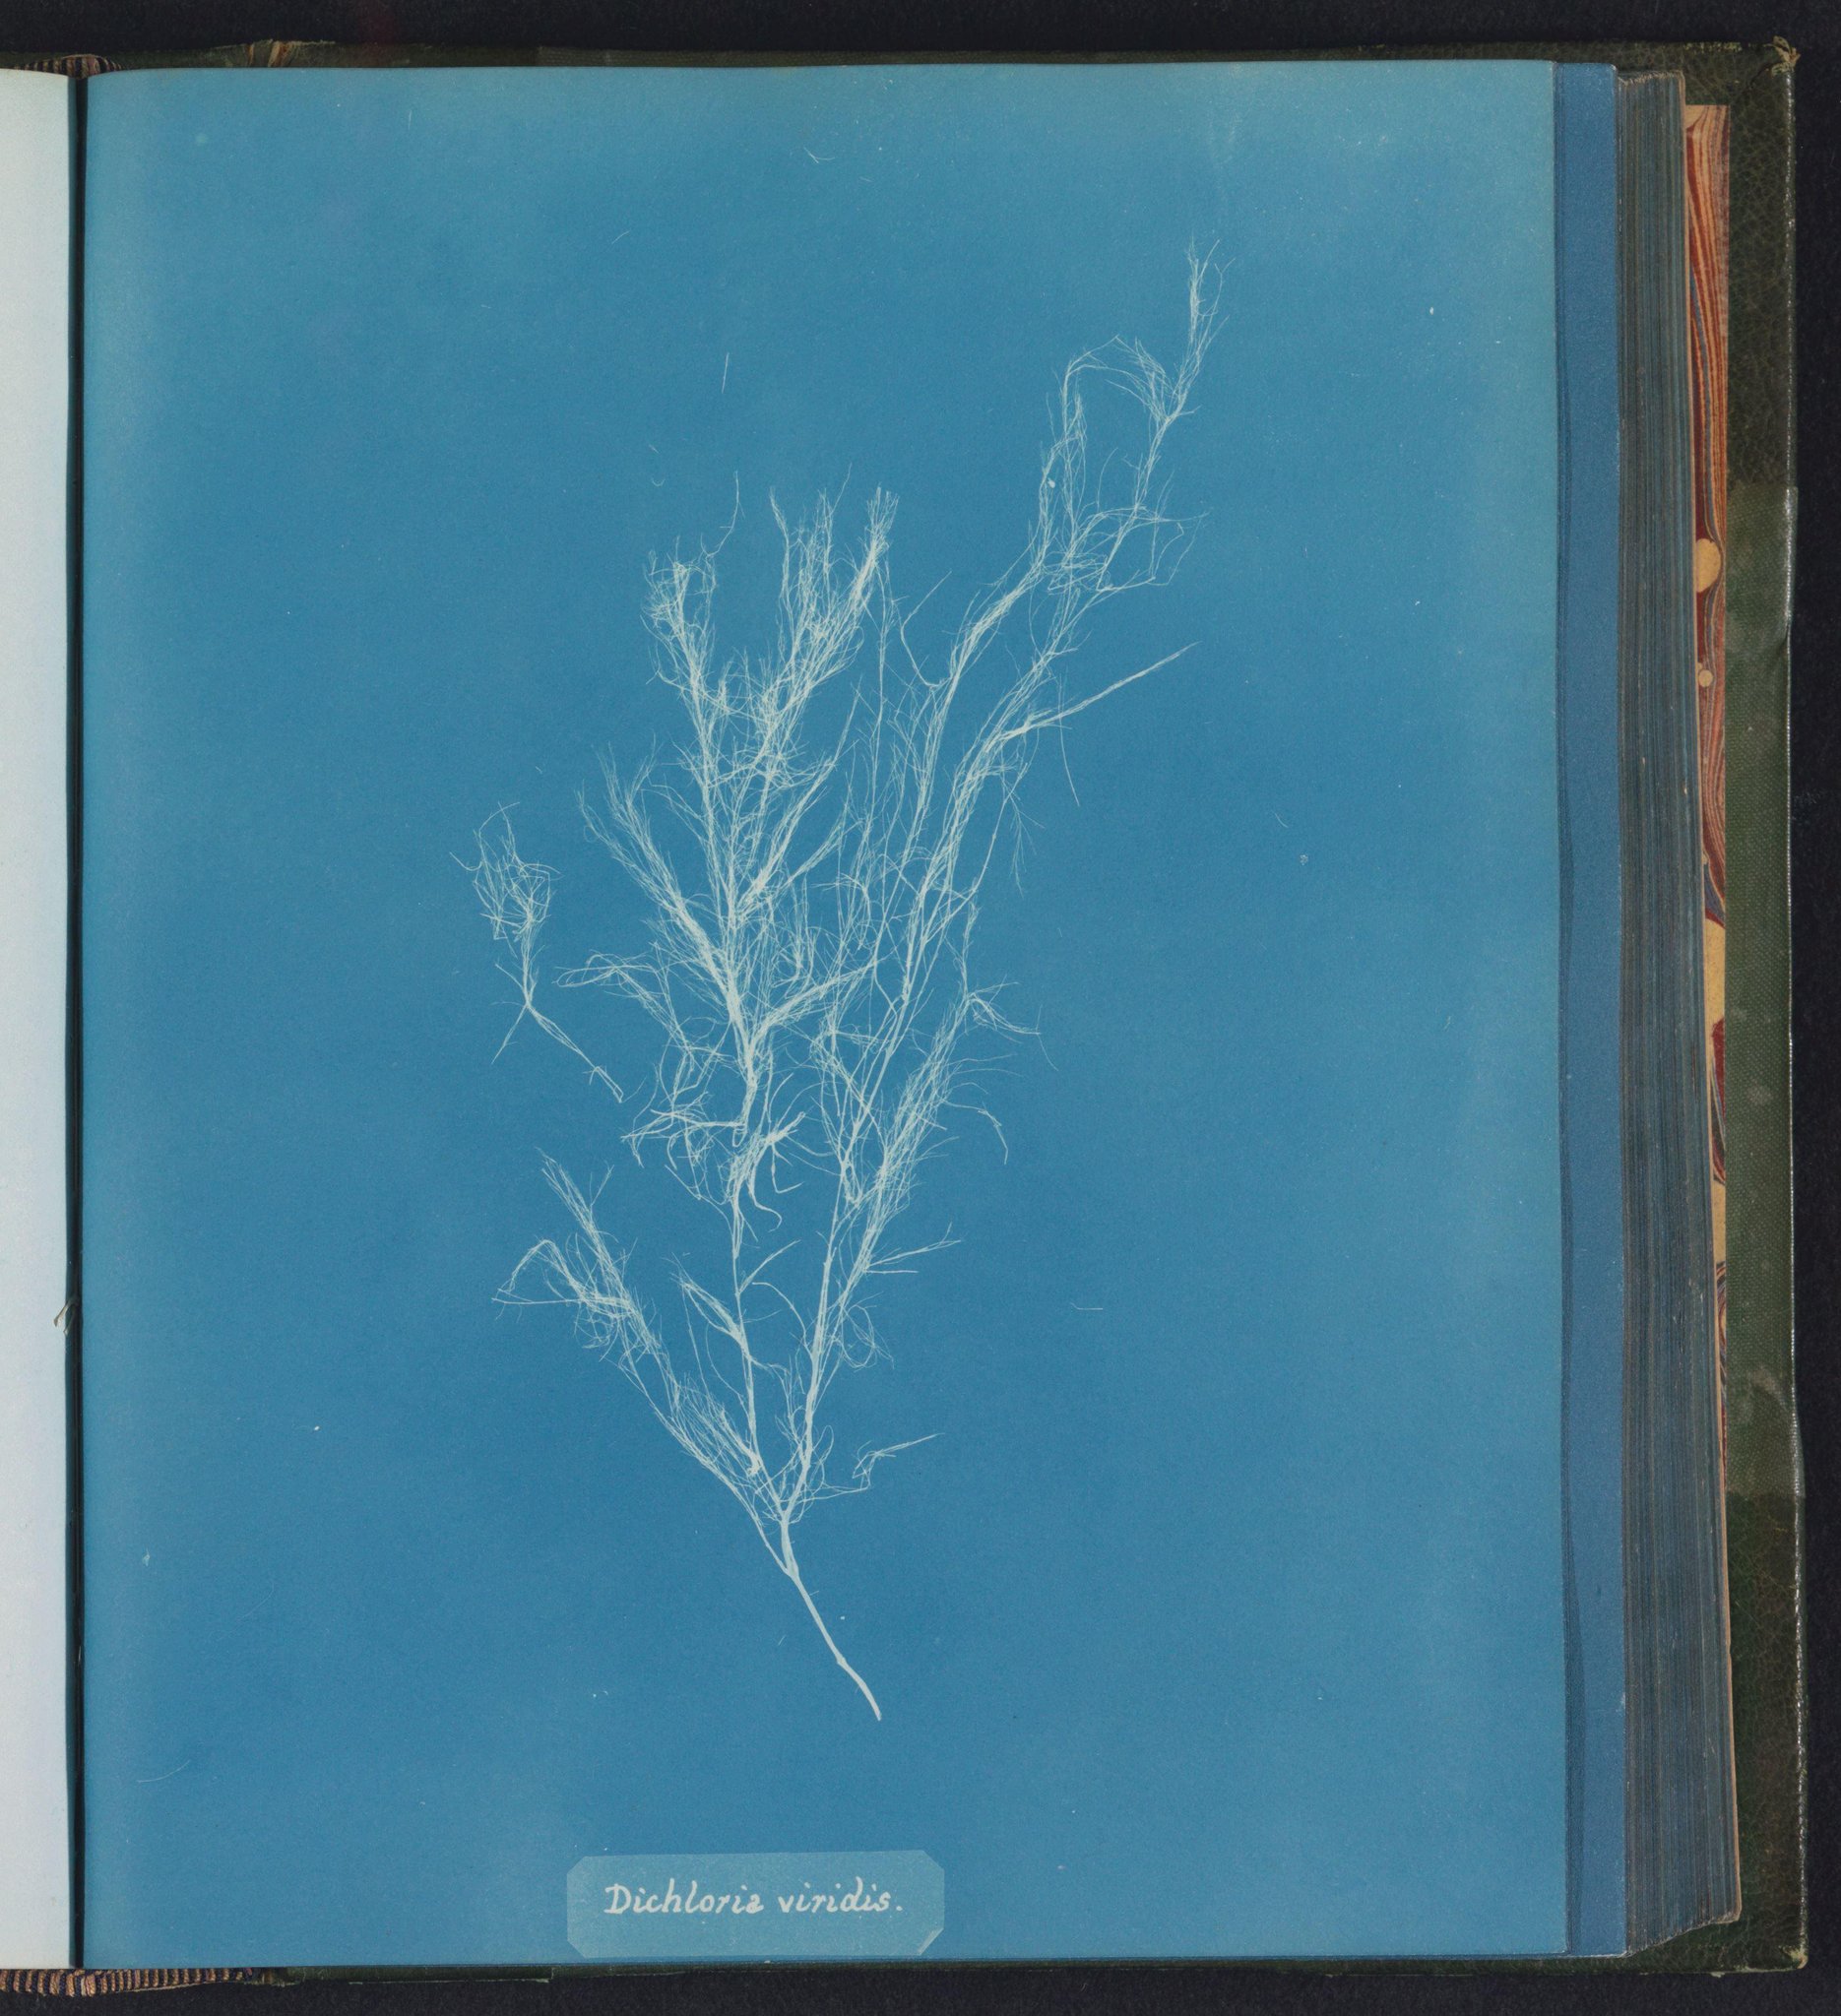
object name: photograph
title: Dichloria viridis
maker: anna atkins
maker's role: fotograaf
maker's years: 1799-1871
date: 1843-1853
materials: photographic support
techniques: cyanotype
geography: united kingdom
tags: algae, seaweed